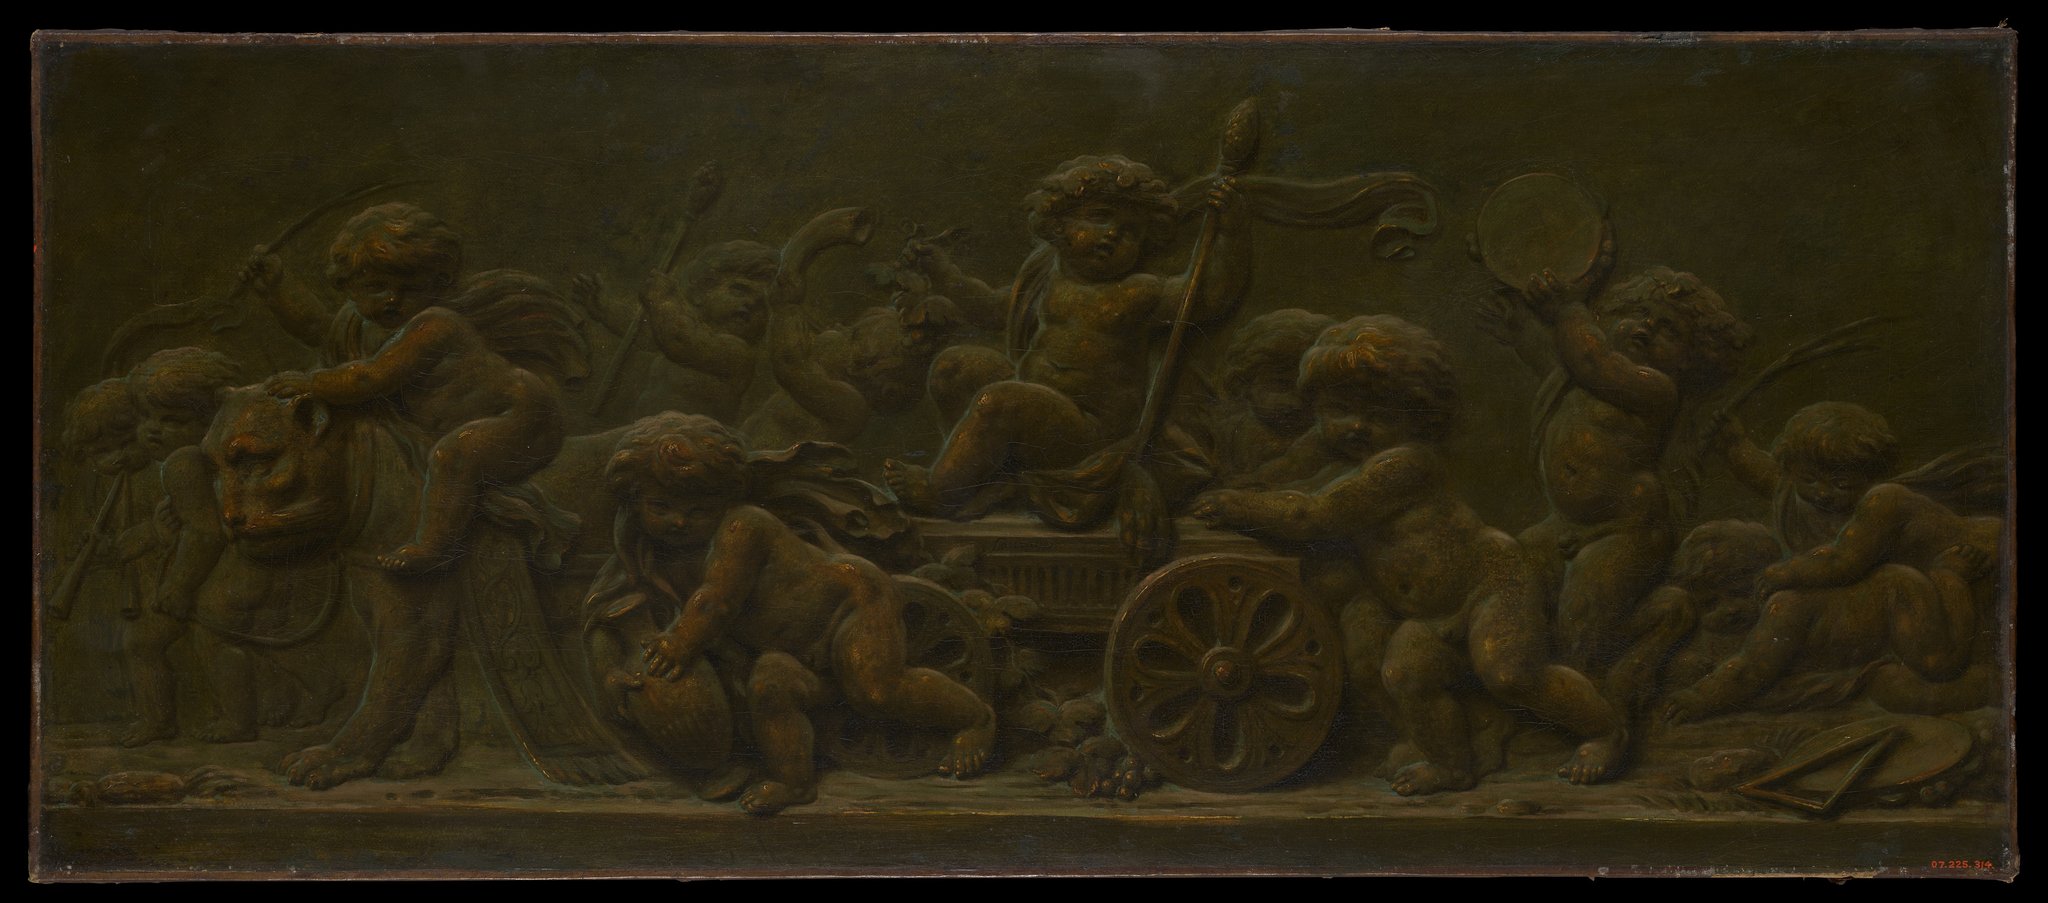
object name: painting, grisaille overdoor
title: The Triumph of Bacchus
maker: piat joseph sauvage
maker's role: artist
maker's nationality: flemish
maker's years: 1744-1818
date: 1780-1789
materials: canvas, oil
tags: putti,bacchus,chariots